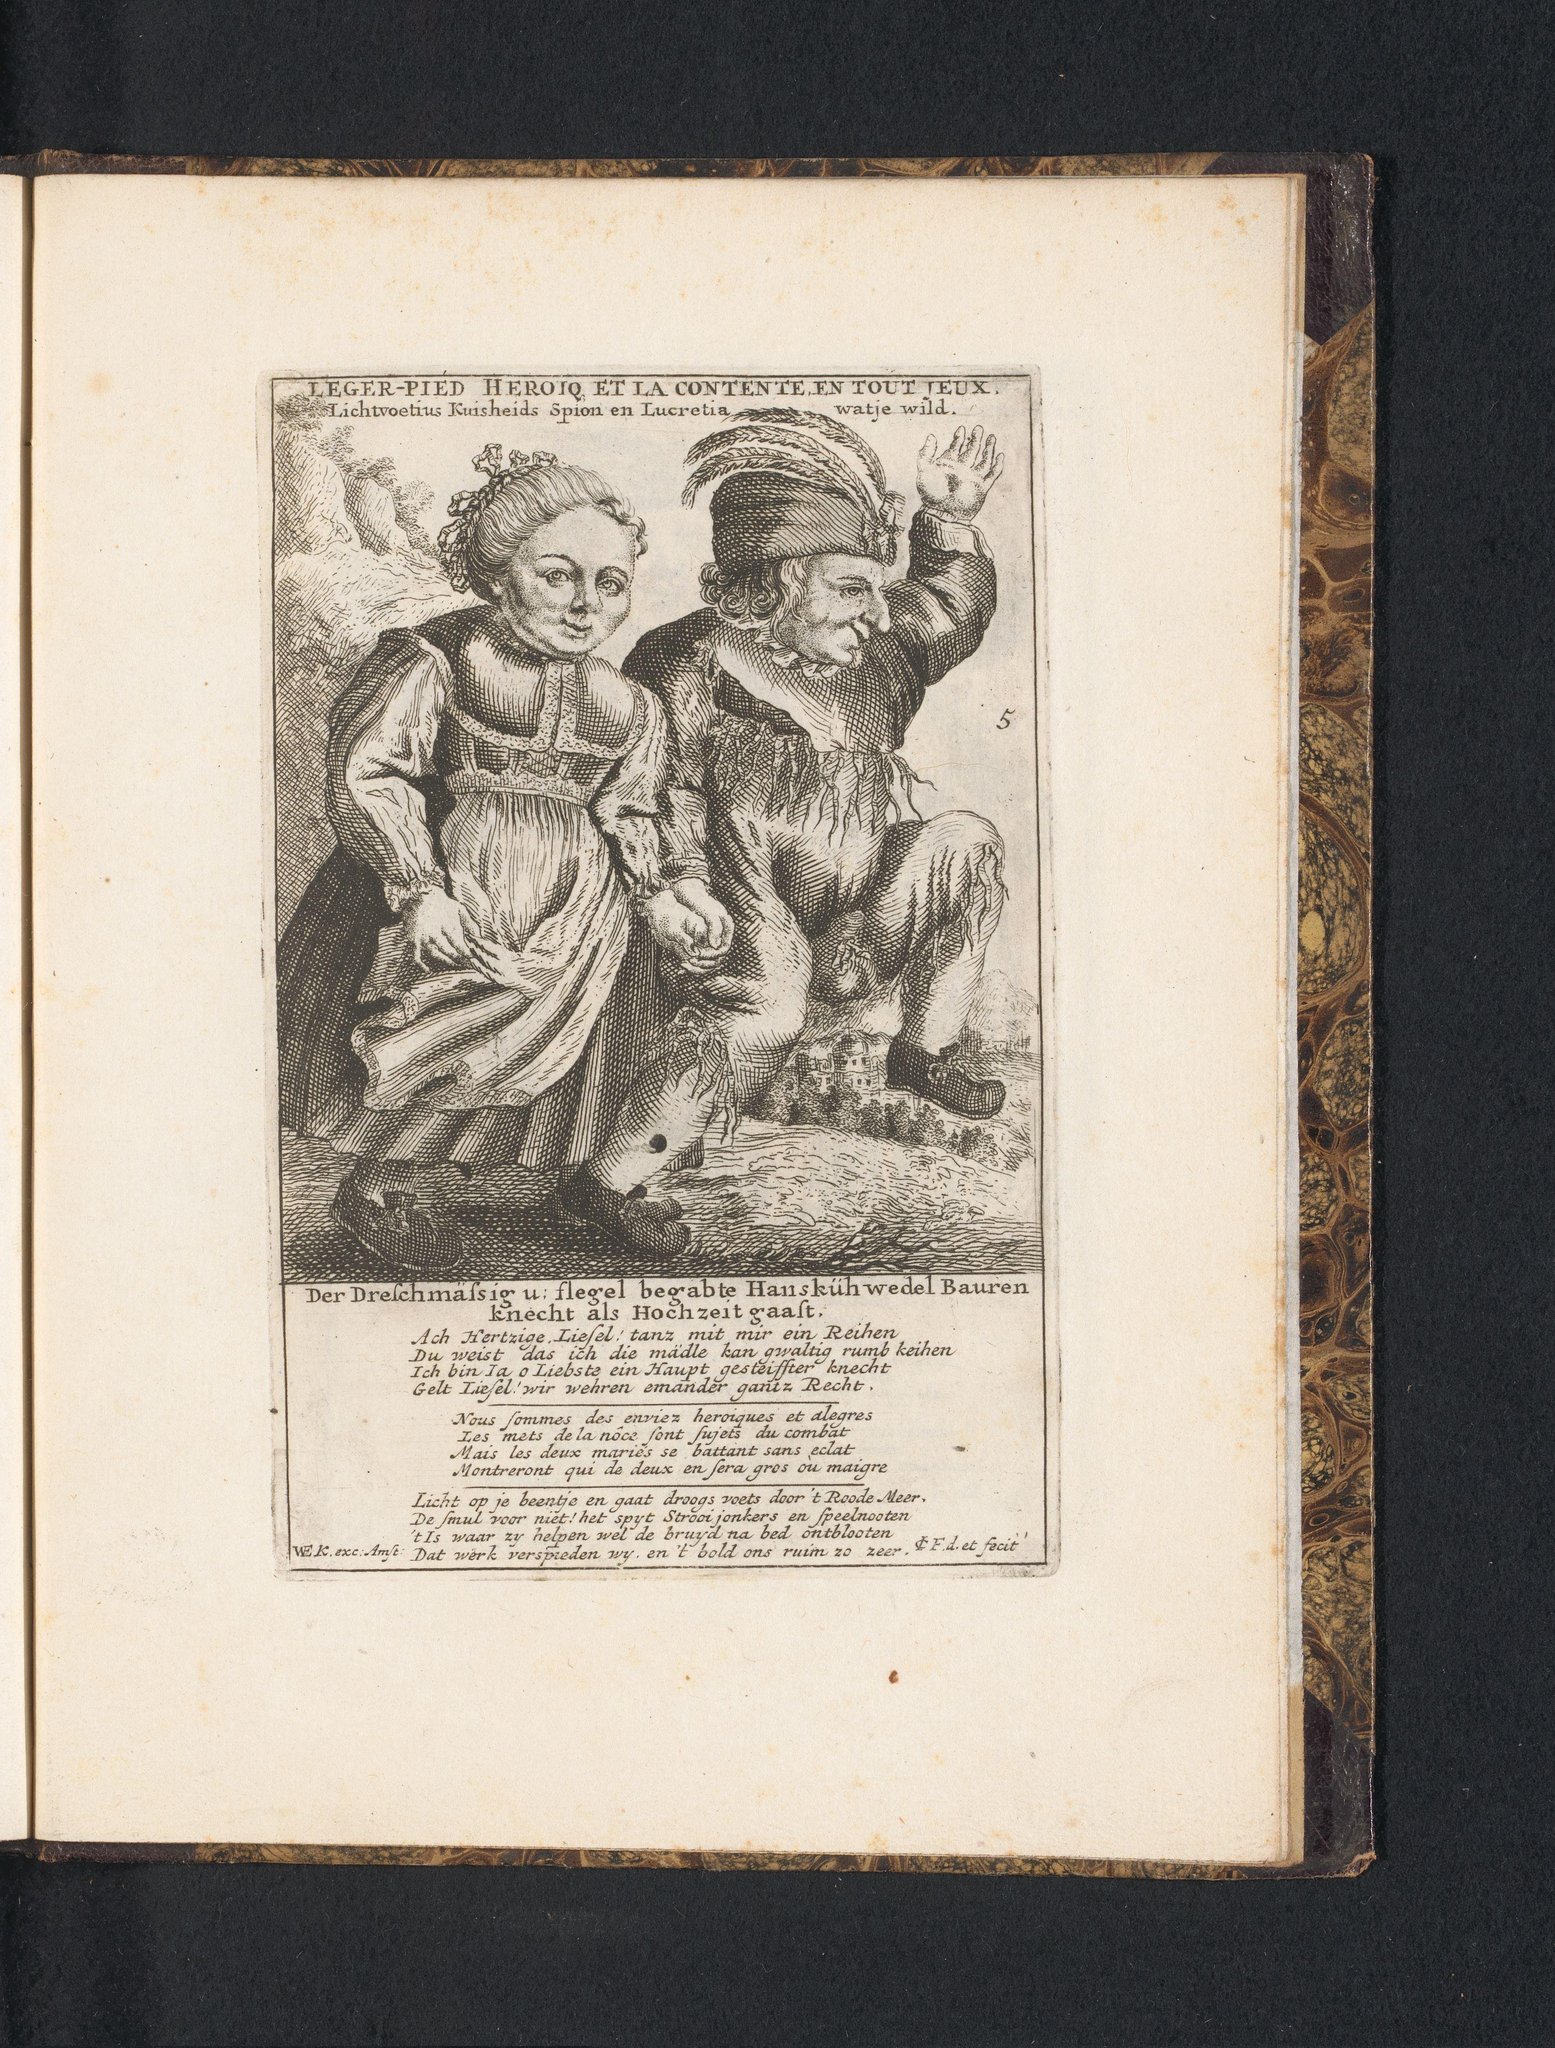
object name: caricature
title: Leger-Pied Heroiq et la Contente en tout jeux / Lichtvoetius Kuisheids Spion en Lucretia watje wild / Der Dreschmässig u: flegel begrabte Hansküh wedel Bauren knecht als Hochzeit graaft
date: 1718-1720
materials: paper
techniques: etching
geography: amsterdam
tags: caricatures (human types), little people, dancing at wedding feast, one pair dancing; man and woman dancing as a couple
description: Dansend paar kleine mensen. In het onderschrift verzen (met seksuele toespelingen) in het Duits, Frans en Nederlands. Afdruk zonder een decoratieve omlijsting. Genummerd rechts midden: 5. Onderdeel van deel IV (een serie van zes platen van dansende paren op een bruiloftsfeest) in de tweede Nederlandse gebonden uitgave uit 1720 (en deels gerelateerd aan de Windhandel in dat jaar) van een serie karikaturen van kleine mensen, bekend als Het Dwergentooneel.